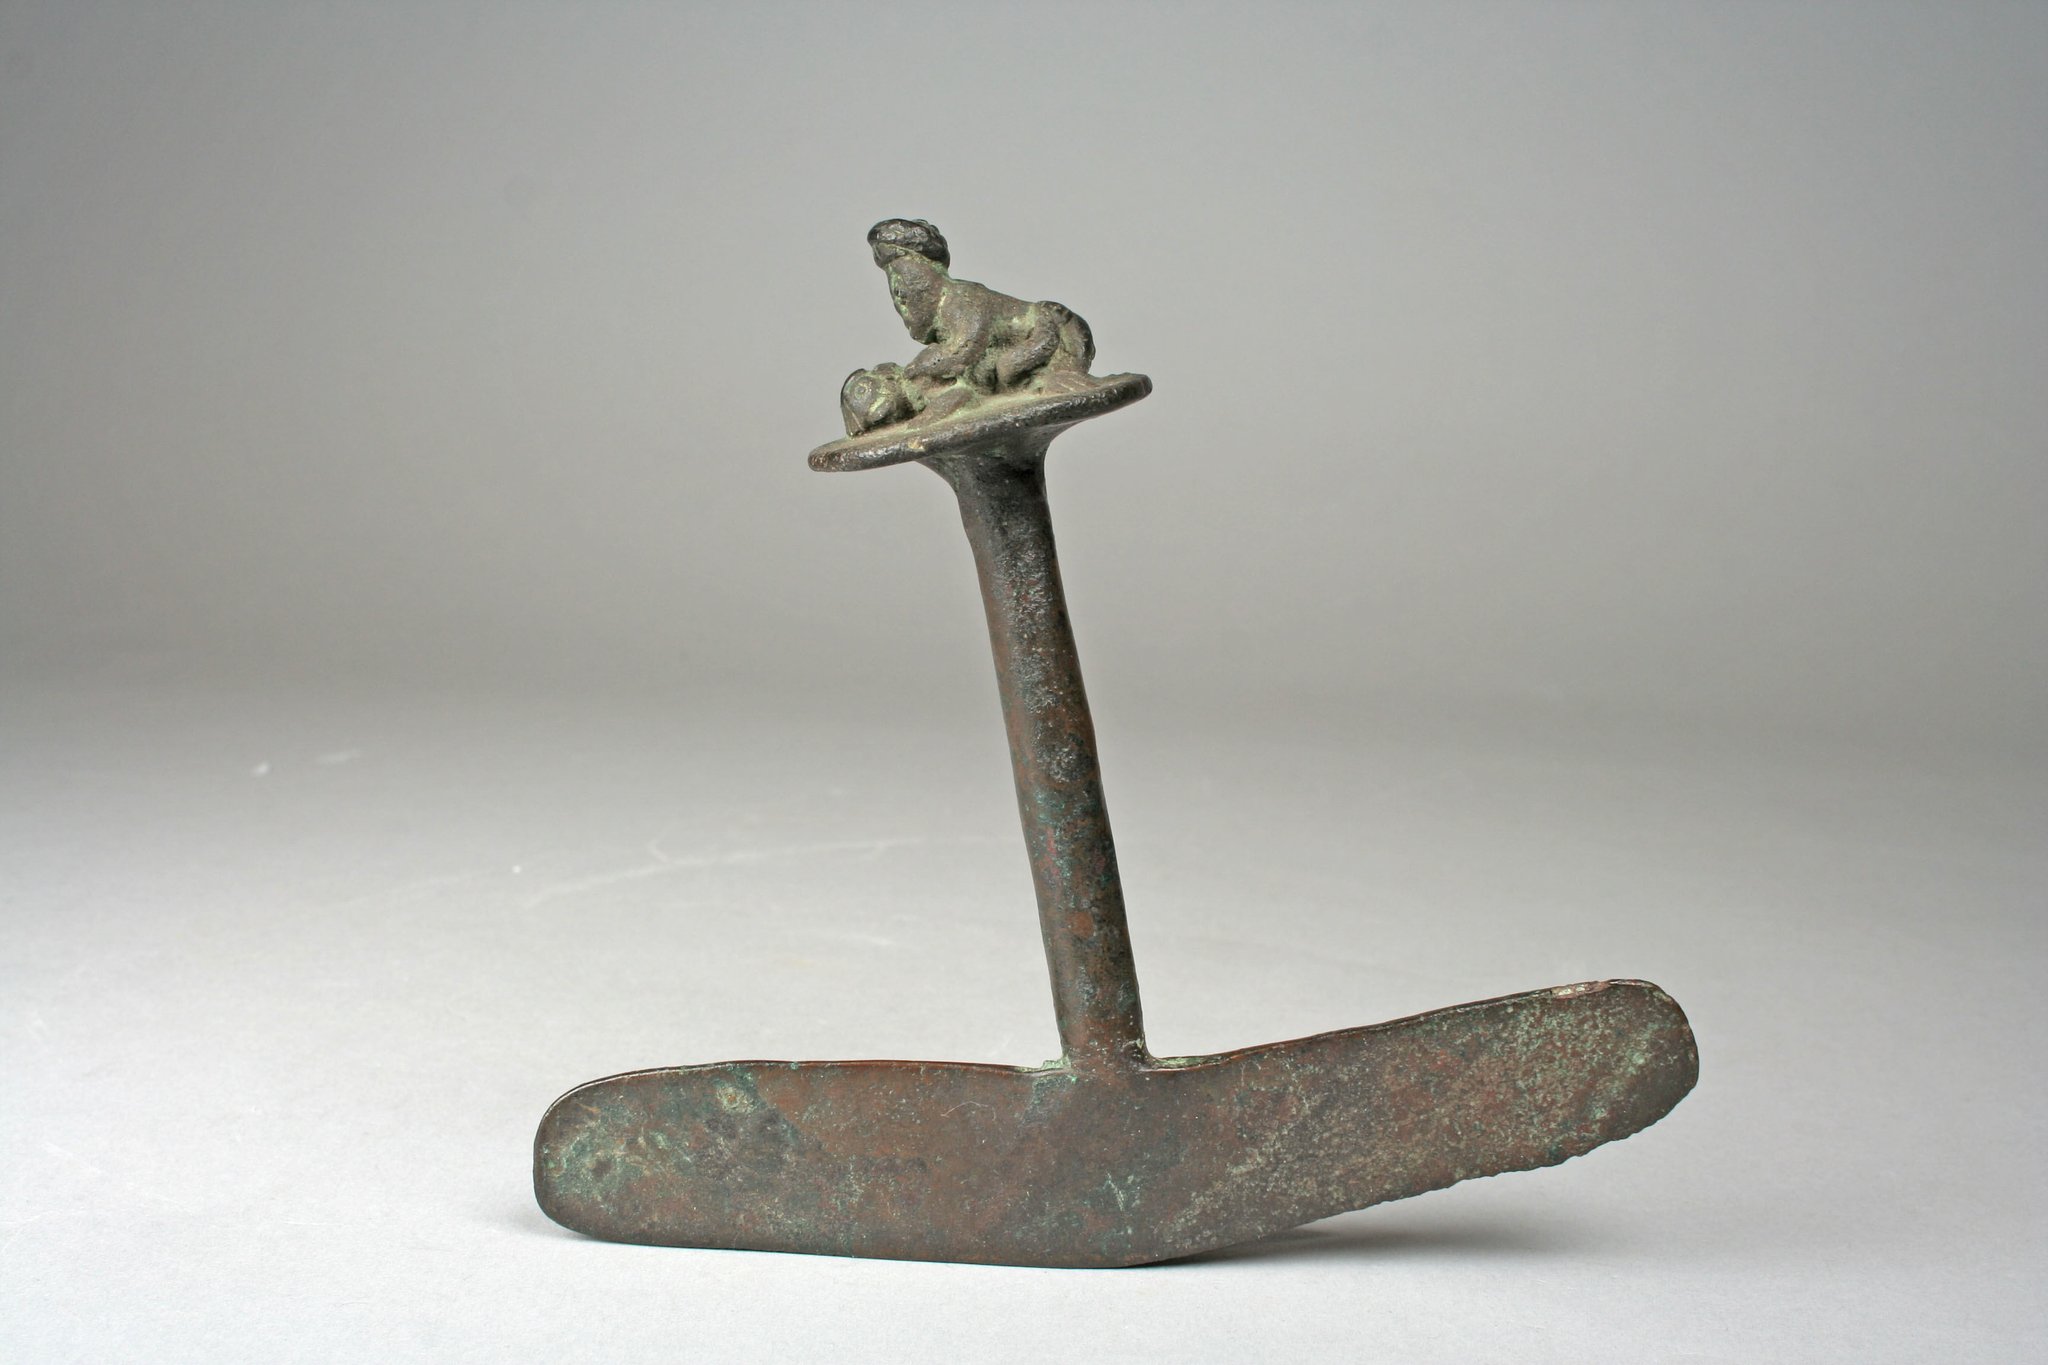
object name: knife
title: Copper Knife with Figure Handle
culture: inca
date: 1301-1500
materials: copper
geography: peru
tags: human figures